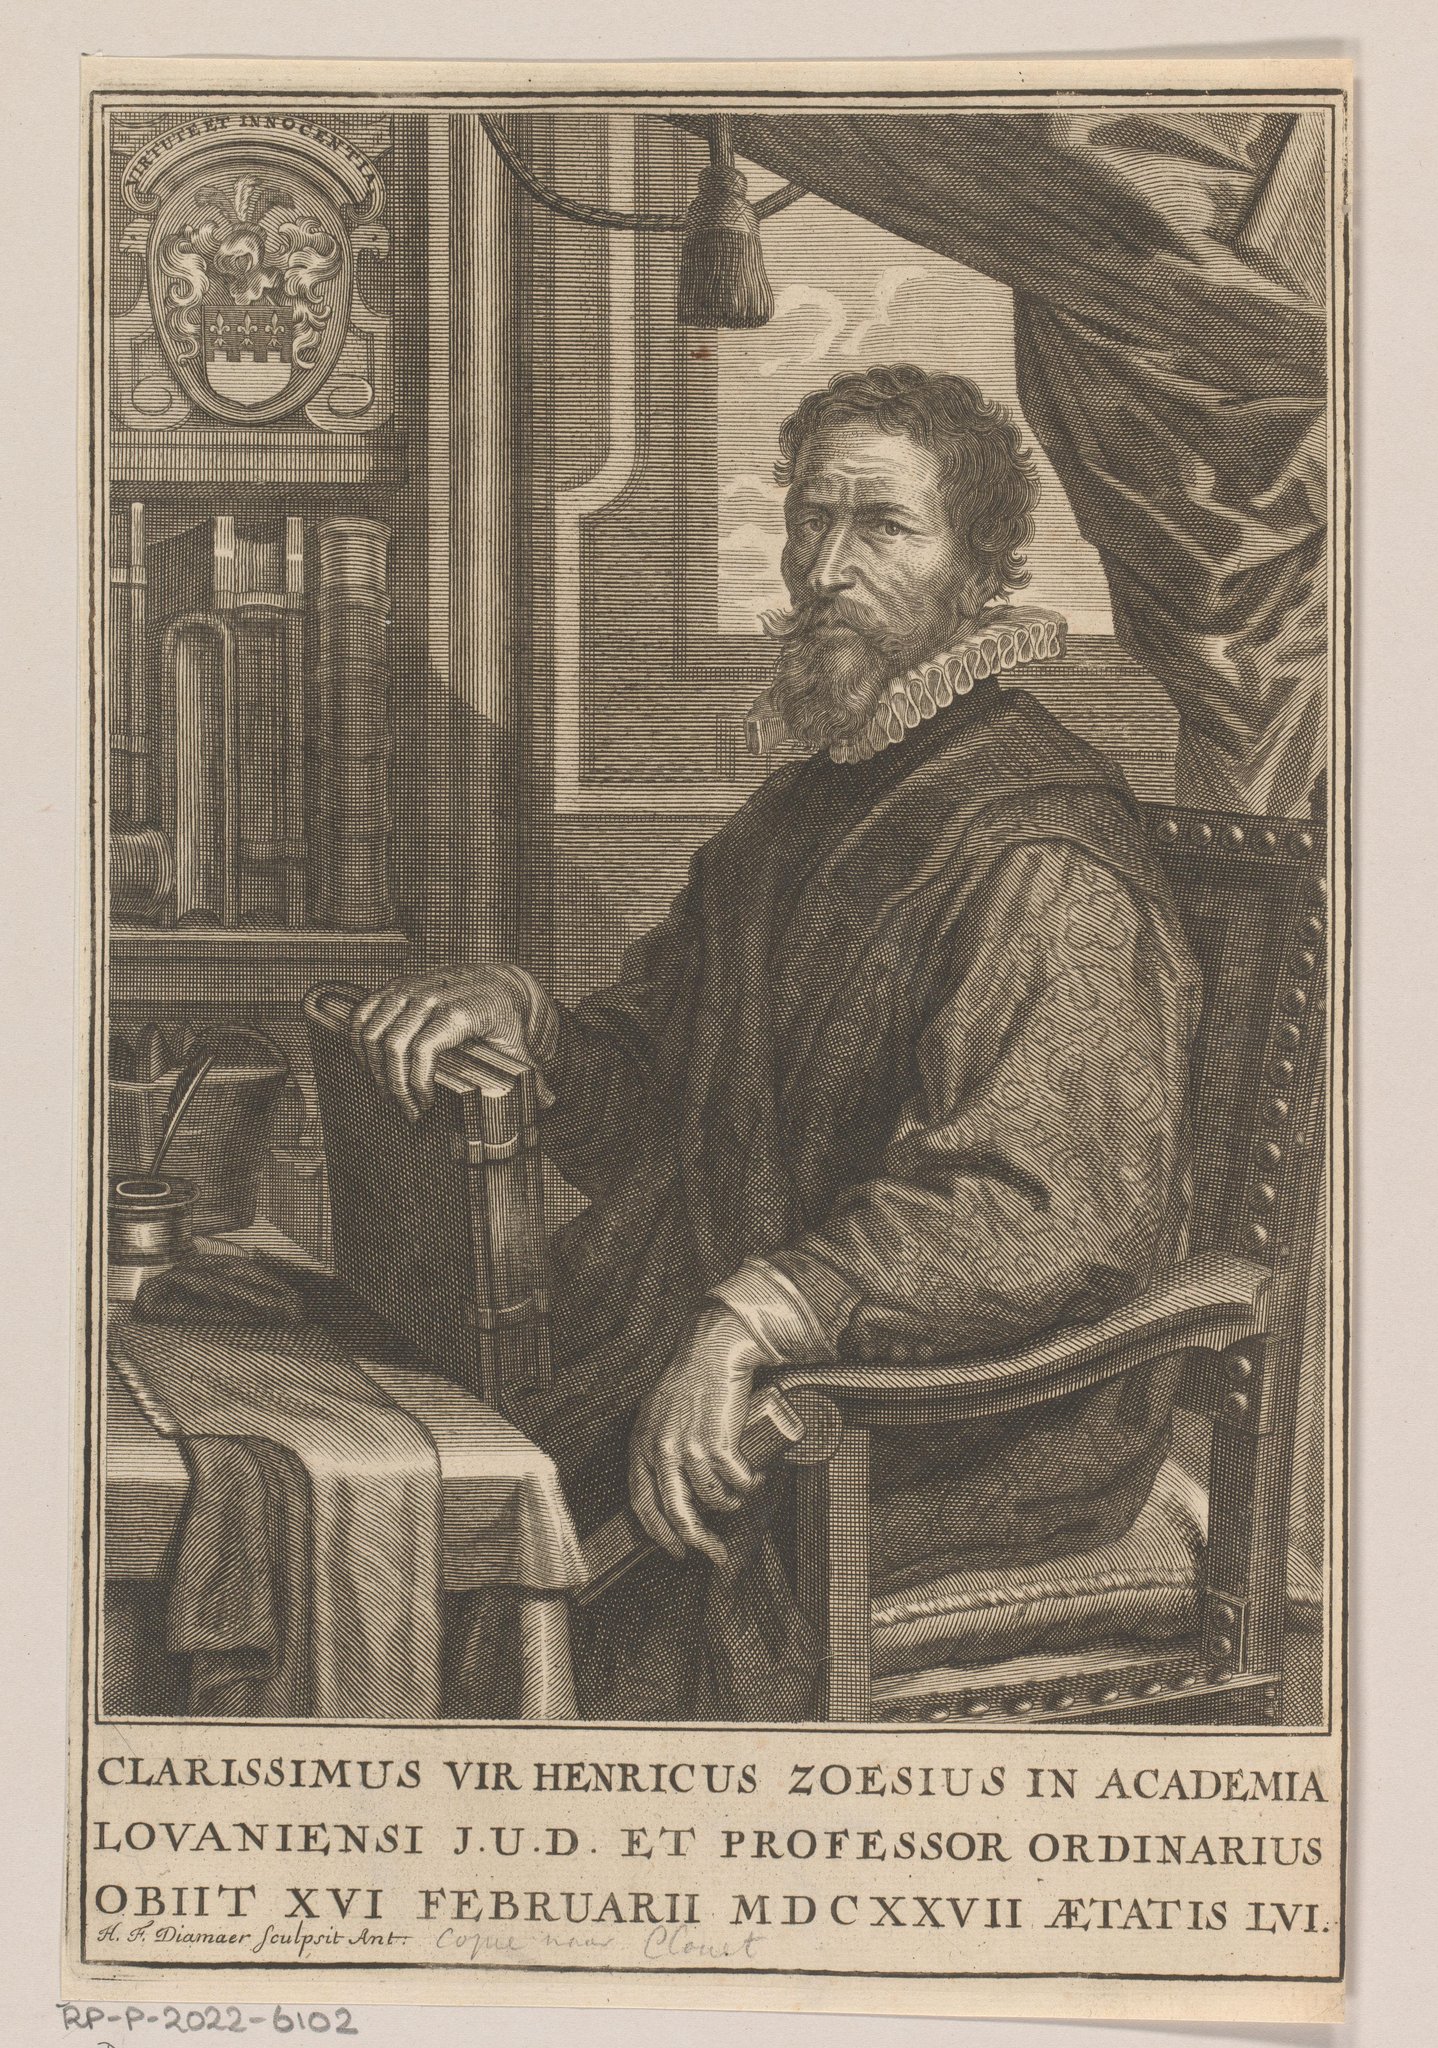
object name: print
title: Portret van Hendrik Zoesius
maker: hendrik frans volkert diamaer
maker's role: print maker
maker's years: 1685-1726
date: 1695-1726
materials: paper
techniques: engraving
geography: antwerp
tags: louvain, historical persons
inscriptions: inscription: ‘Copie naar Clouet’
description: Met drieregelig onderschrift in het Latijn.